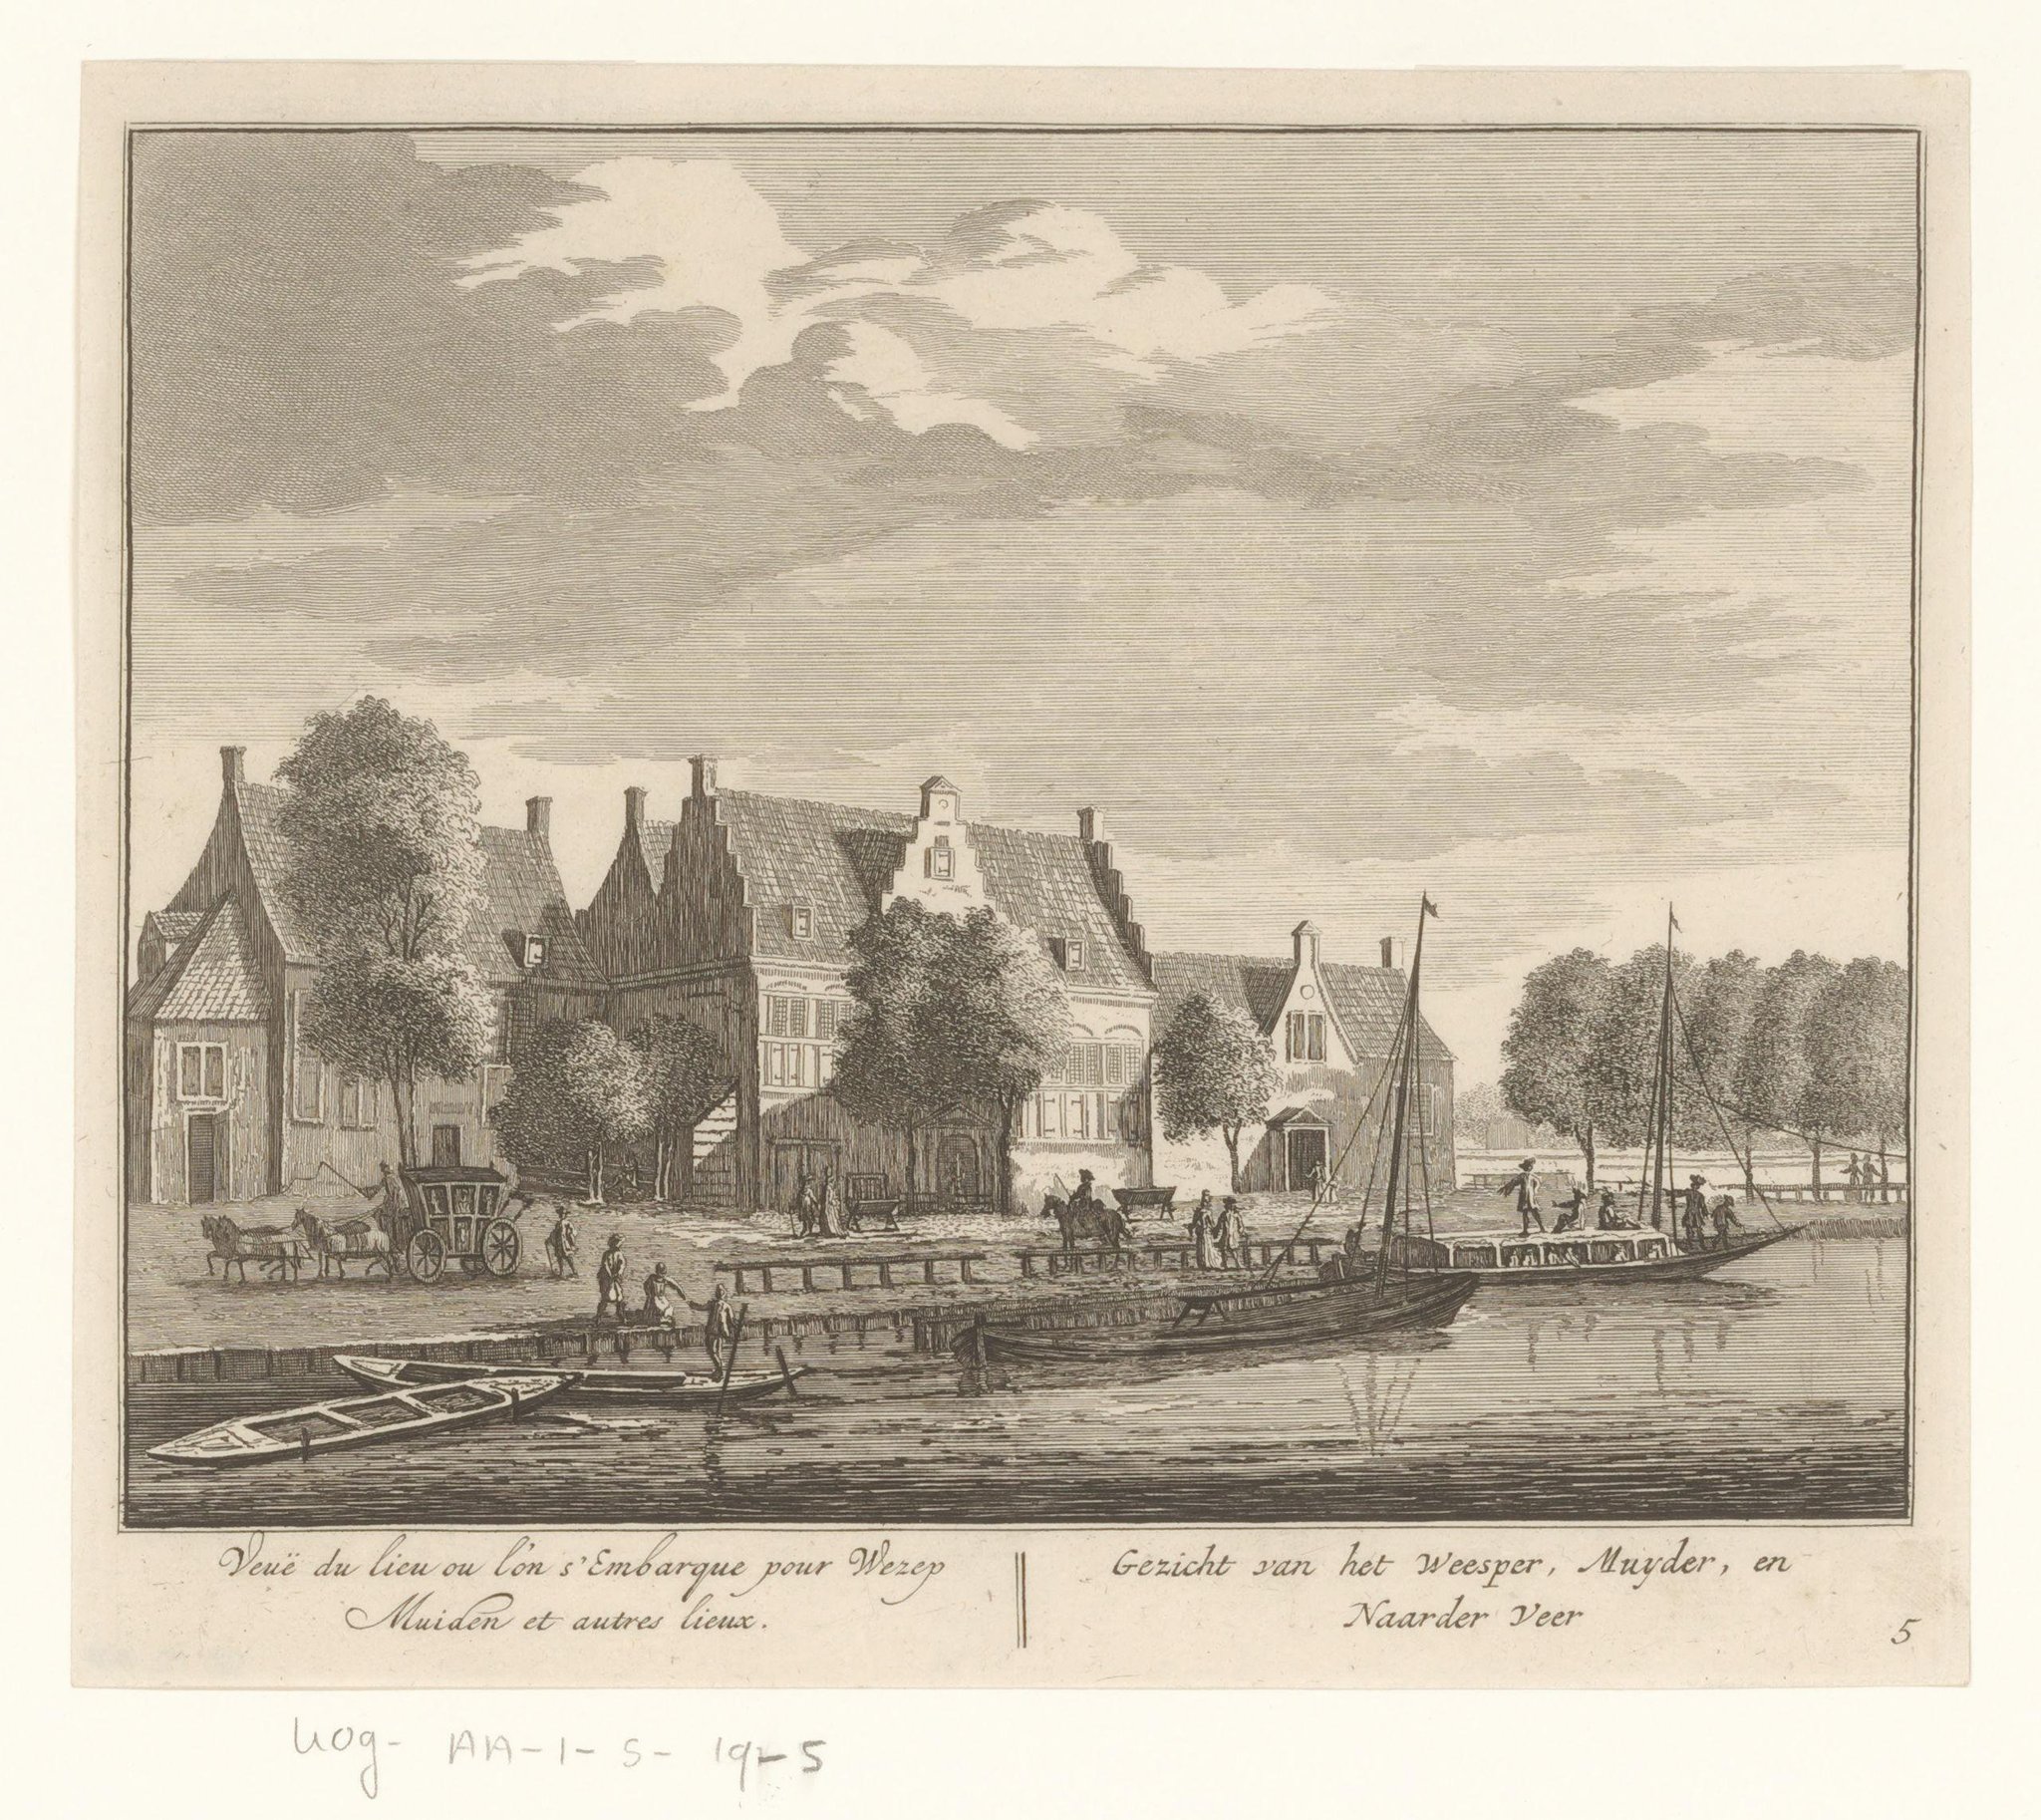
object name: print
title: Hollands Arcadia, of de vermaarde rivier den Amstel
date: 1730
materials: paper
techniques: etching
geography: amsterdam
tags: city-view in general; 'veduta', river, inn, coffee-house, public house, etc., boat propelled by man or animal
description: Prent waarschijnlijk uit: Tijsens, Gijsbert. Hollands Arcadia, of de vermaarde rivier den Amstel (...) naar 't léven getekend en in 't ligt gebragt door Abraham Rademaker (...). Amsterdam: Leonardus Schenk, 1730.